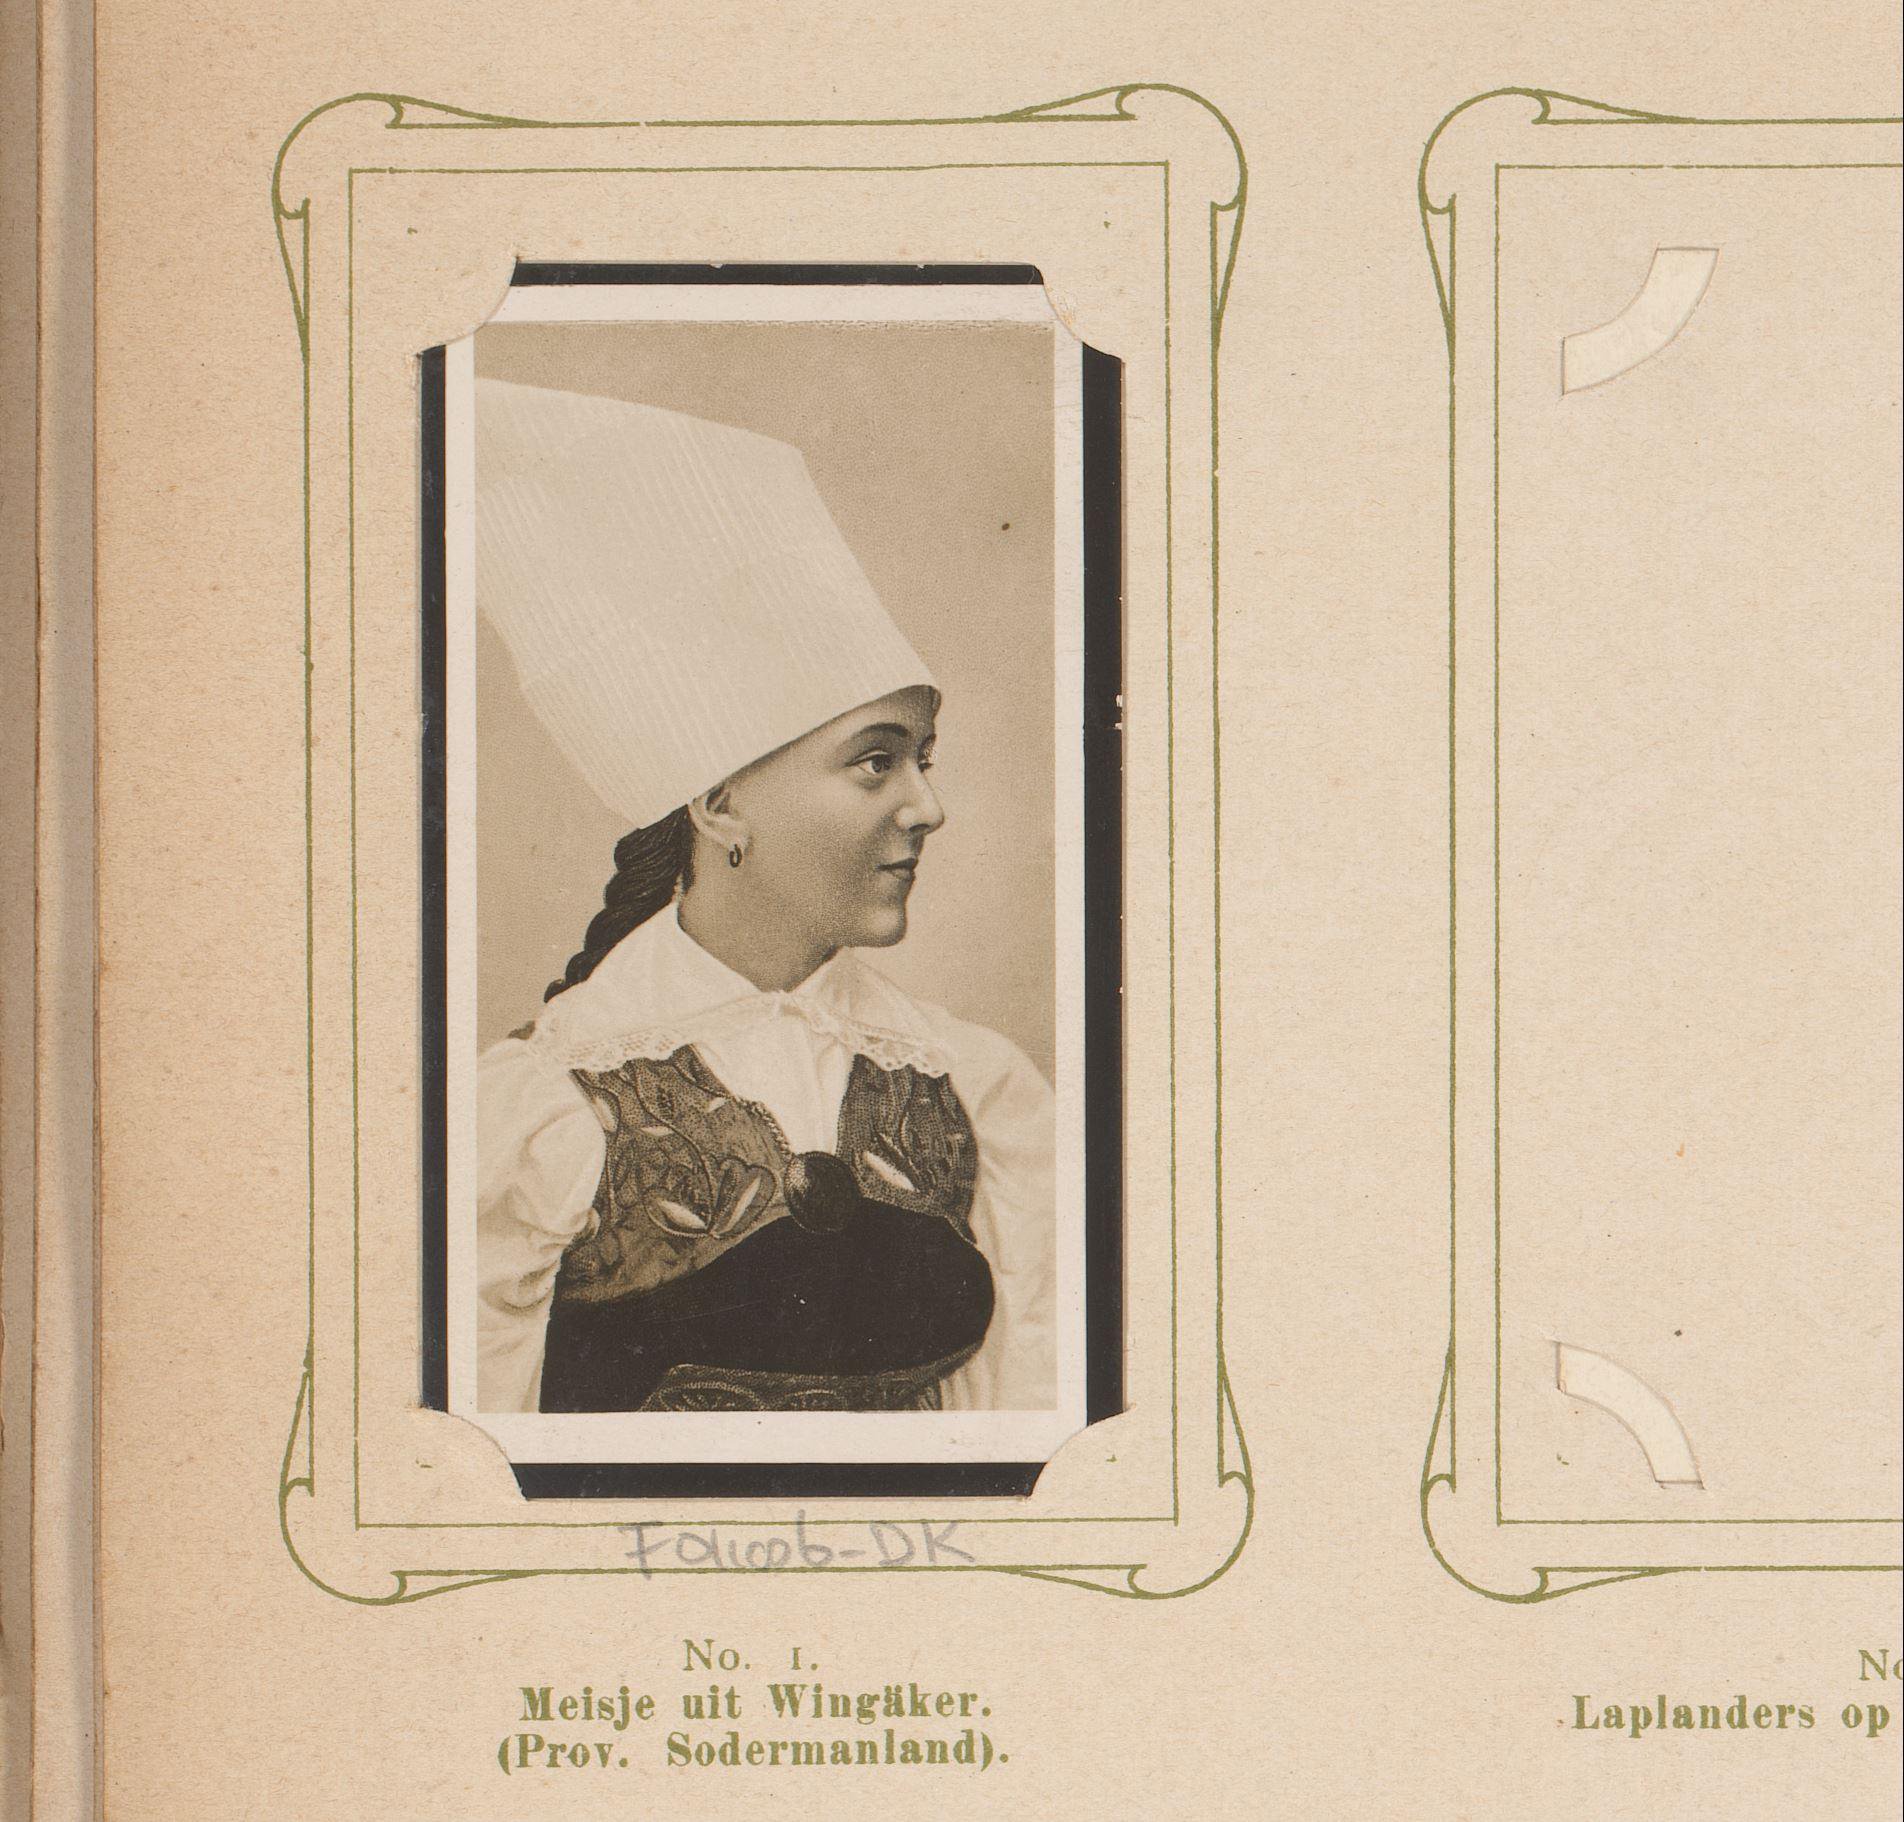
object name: photograph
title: Zweedse vrouw in traditionele kleding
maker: Anonymous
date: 1904-1905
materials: photographic support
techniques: gelatin silver print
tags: head-gear, historical persons - bb - woman, folk costume, regional costume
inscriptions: inscription: ‘No. 1./ Meisje uit Wingäker./ (Prov. Sodermanland).’